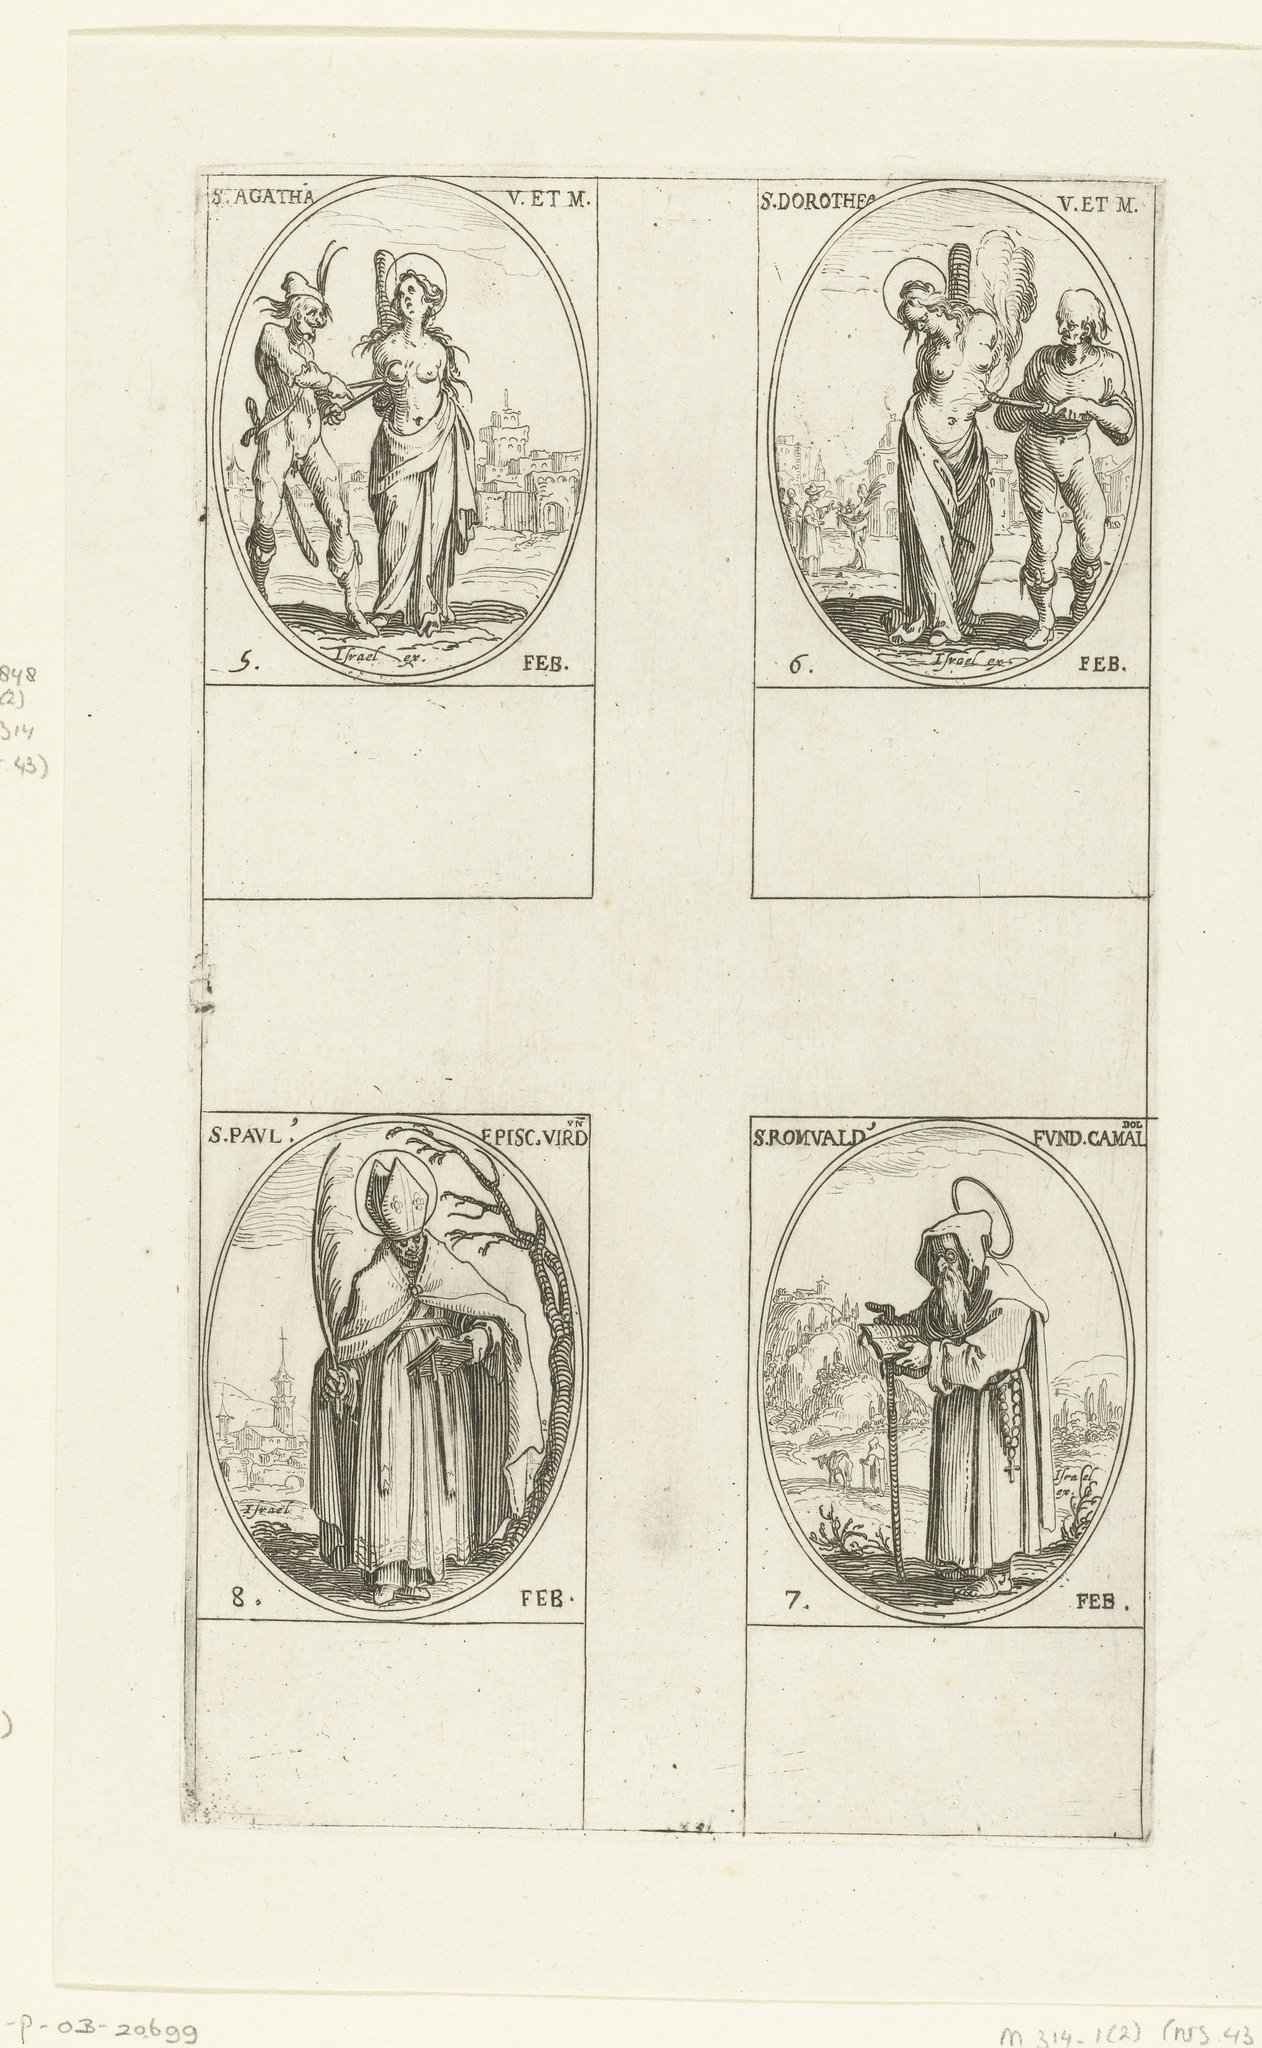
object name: print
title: Alle heiligen en de Christelijke feestdagen van het jaar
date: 1632-1636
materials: paper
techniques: etching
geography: nancy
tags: male saints (with name), the benedictine monk romuald of camaldoli (or ravenna), founder of the camaldolese order; possible attributes: book, t-shaped staff, martyrdom, suffering, misfortune, death of st. dorothea, the breasts of st. agatha are cut or sheared off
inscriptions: collector's mark: Lugt 240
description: Blad met vier ovale voorstellingen, elk met opschrift en datum in het Latijn: linksboven de Heilige Agatha wier borsten door een beul worden afgesneden, rechtsboven de Heilige Dorothea gebonden aan een paal, rechtsonder de Heilige Romuald met een wandelstok en een boek in de handen, linksonder de Heilige Paulus van Verdun met een palmtak in de hand. Deze prent is onderdeel van een serie prenten met voorstellingen van de heiligen en de christelijke feestdagen van het jaar. Er zijn steeds vier scènes van één plaat op één blad gedrukt. Inclusief bijbehorend titelblad en frontispice gaat het in totaal om 124 platen (490 voorstellingen). De drie platen met de laatste 12 scènes (de veranderlijke christelijke feestdagen) zijn in de derde staat versneden tot 12 kleine plaatjes, en met een apart titelblad uitgegeven.